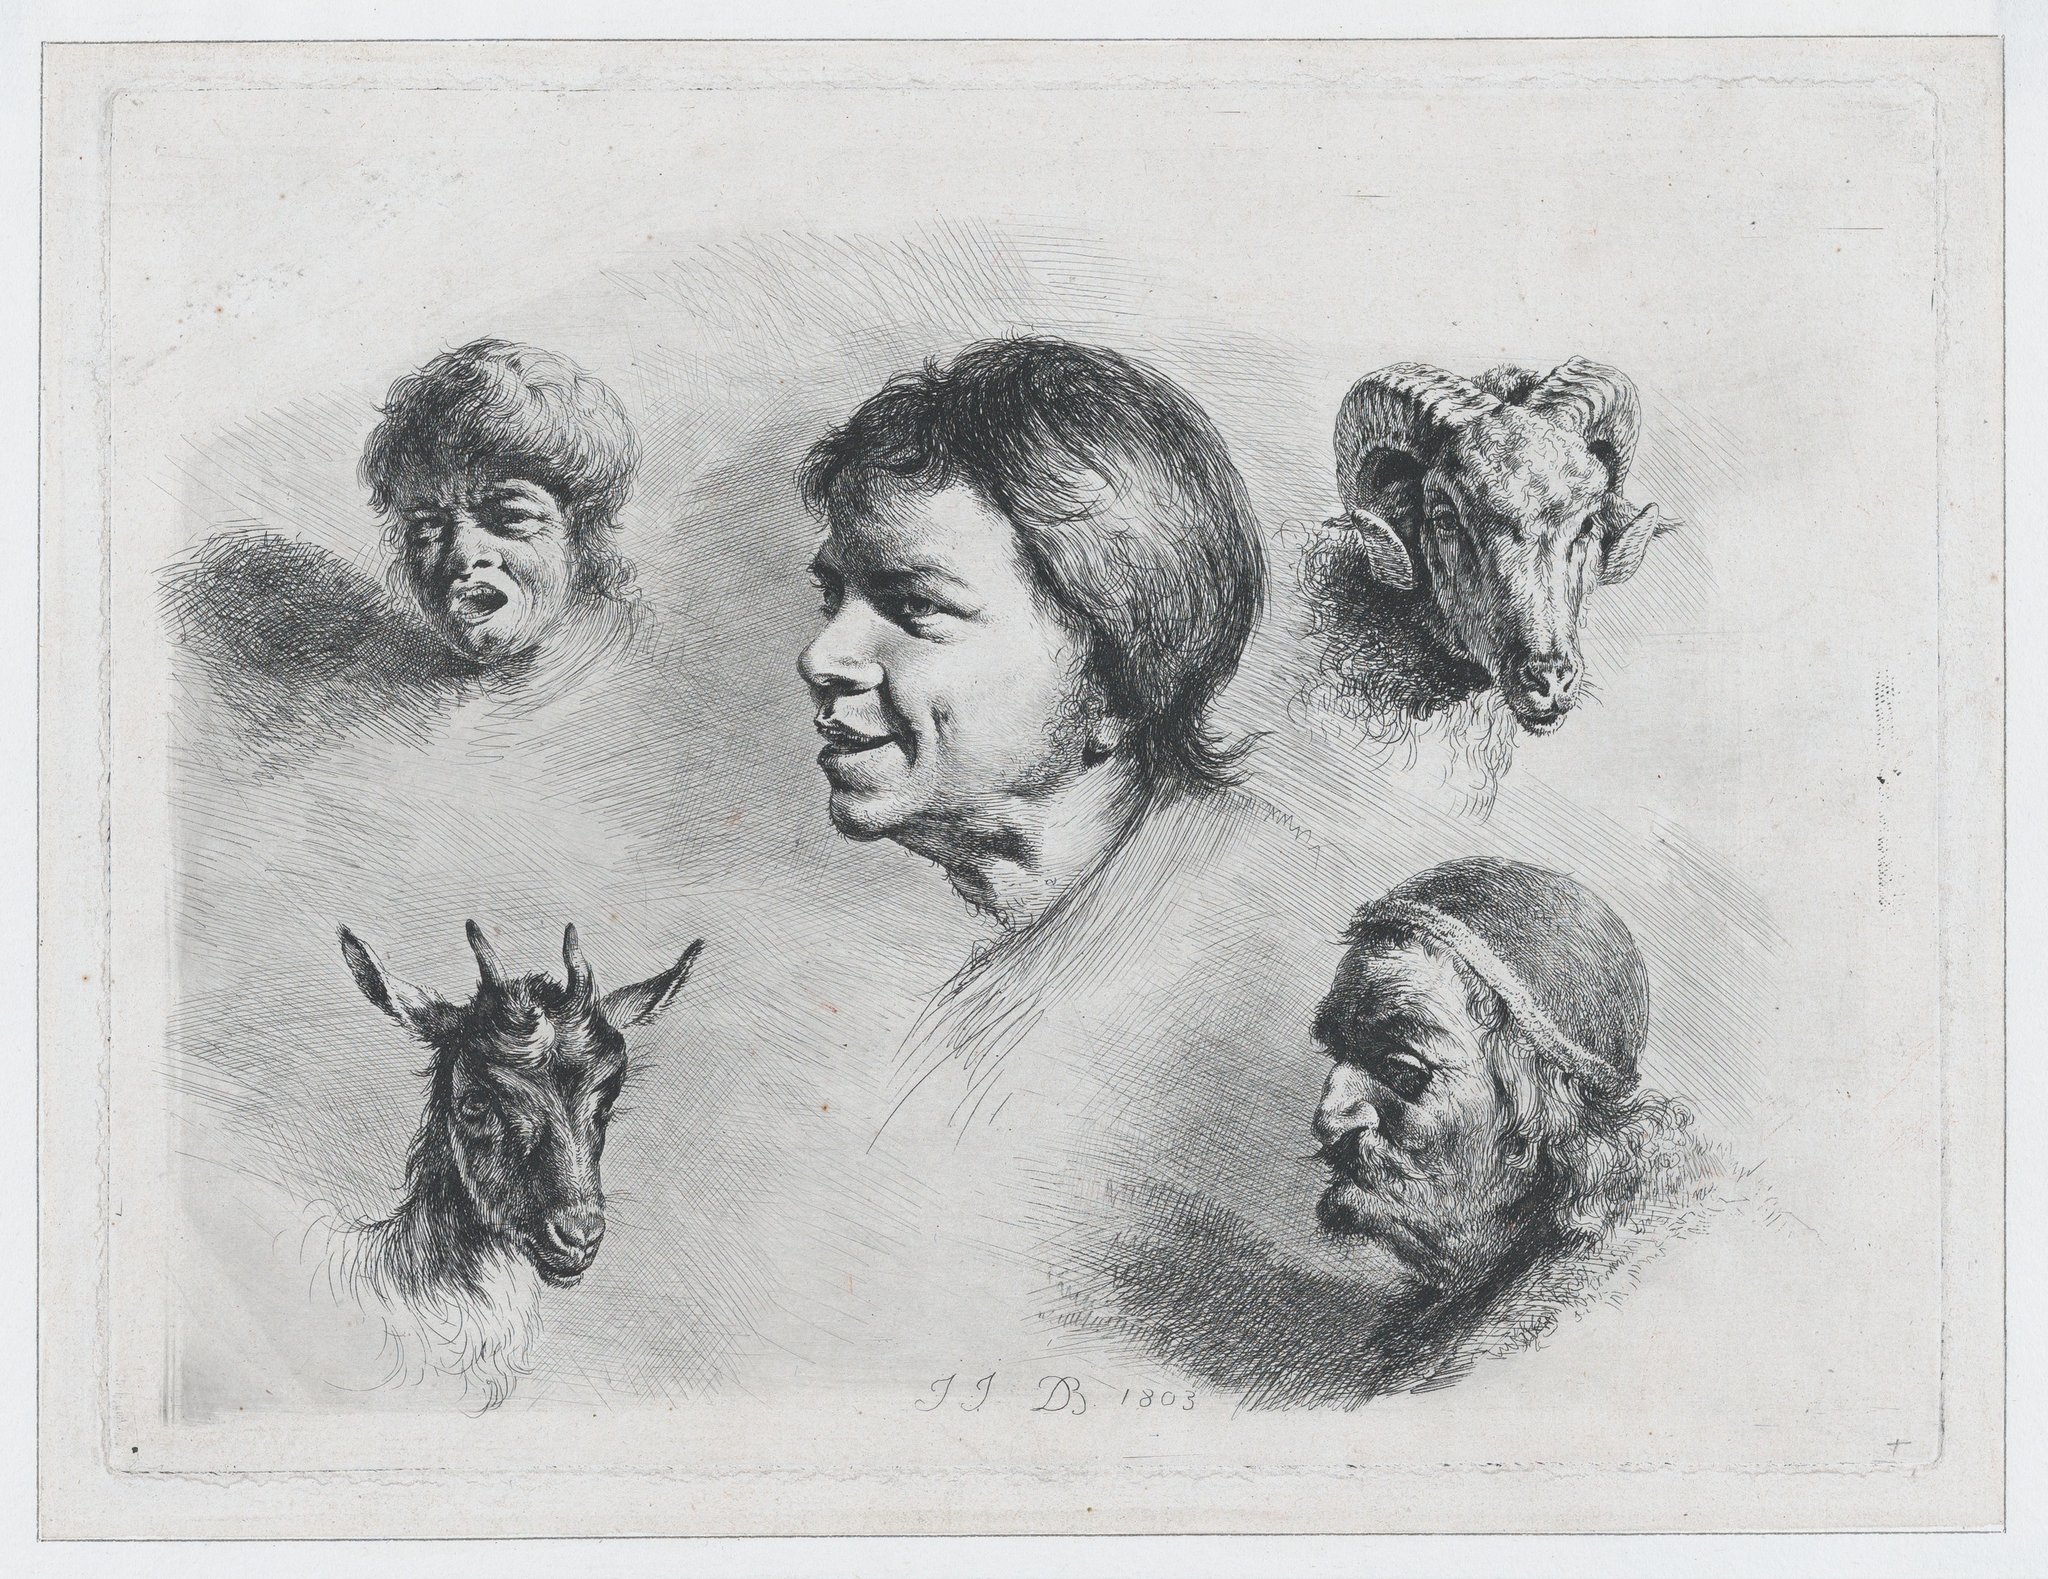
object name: print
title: Study of Five Heads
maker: jean jacques de boissieu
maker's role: artist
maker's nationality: french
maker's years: 1736-1810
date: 1803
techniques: etching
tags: animals,heads,boys,men